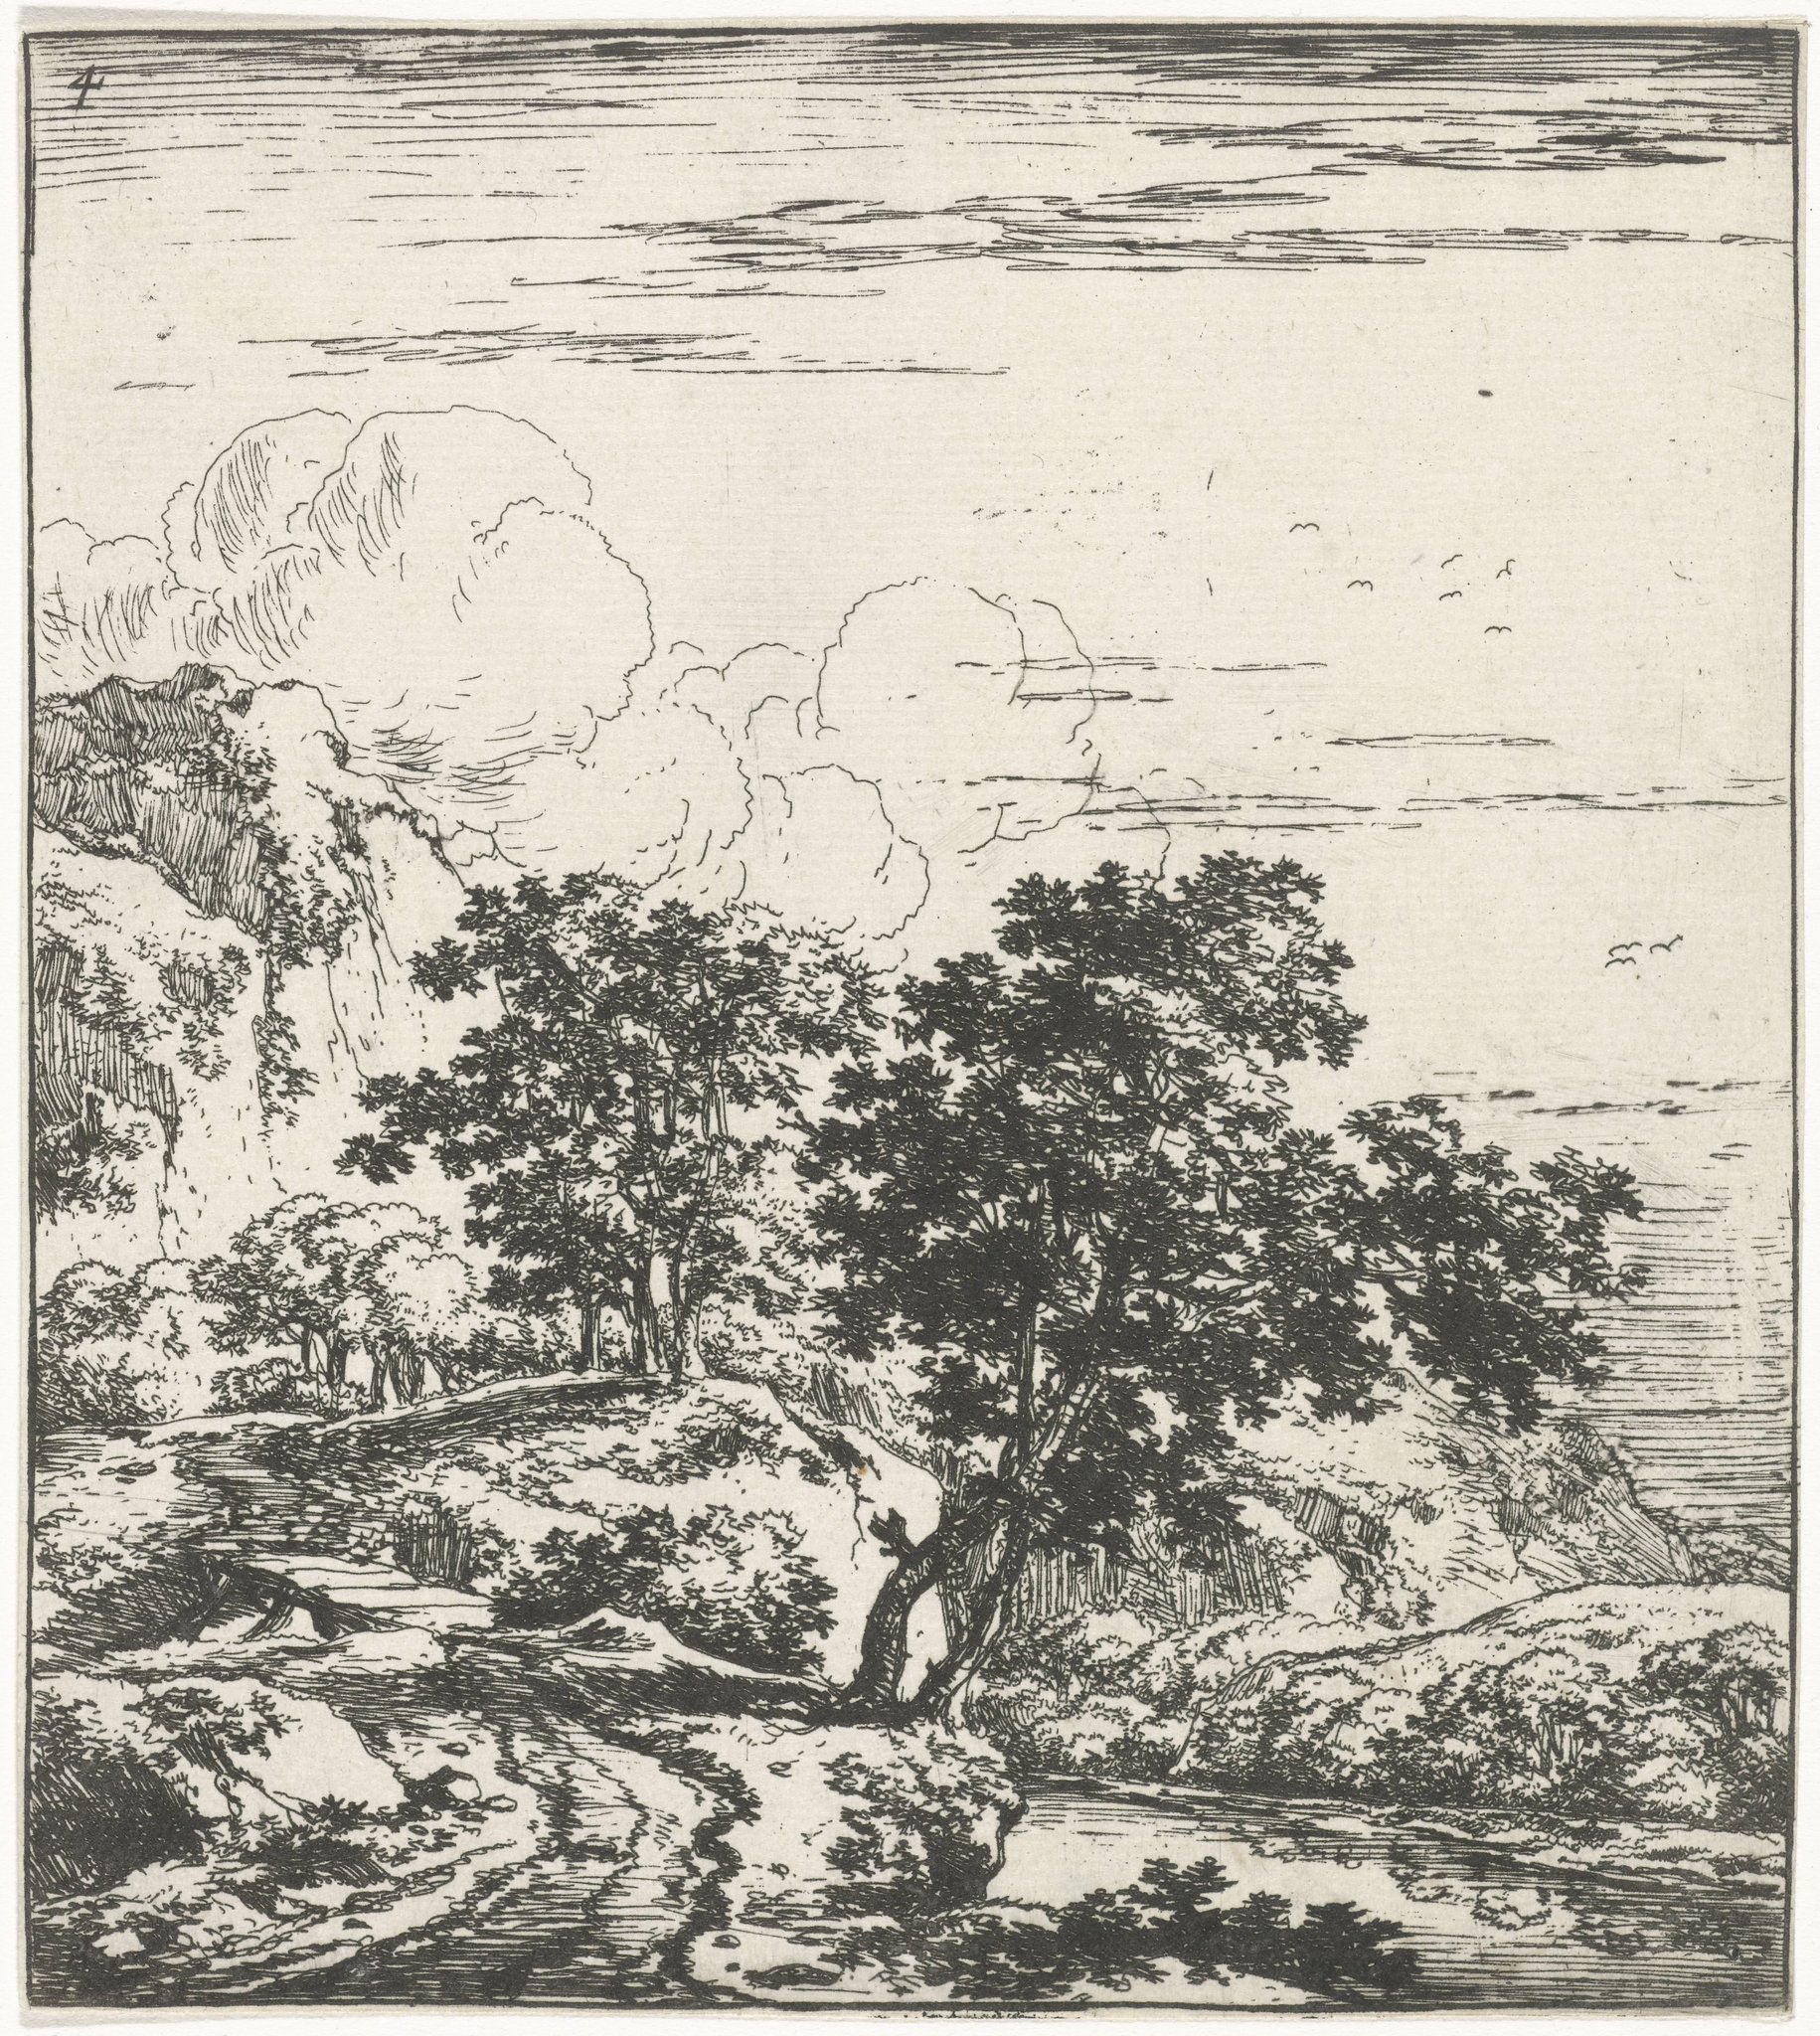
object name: print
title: Weg met een brug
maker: herman naiwincx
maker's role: draughtsman, print maker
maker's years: 1623-1670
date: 1633-1670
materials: paper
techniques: etching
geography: amsterdam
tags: river, bridge, mountains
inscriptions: collector's mark: Lugt 240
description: Links een weg met een houten brug in een bergachtig landschap. Rechts een rivier.